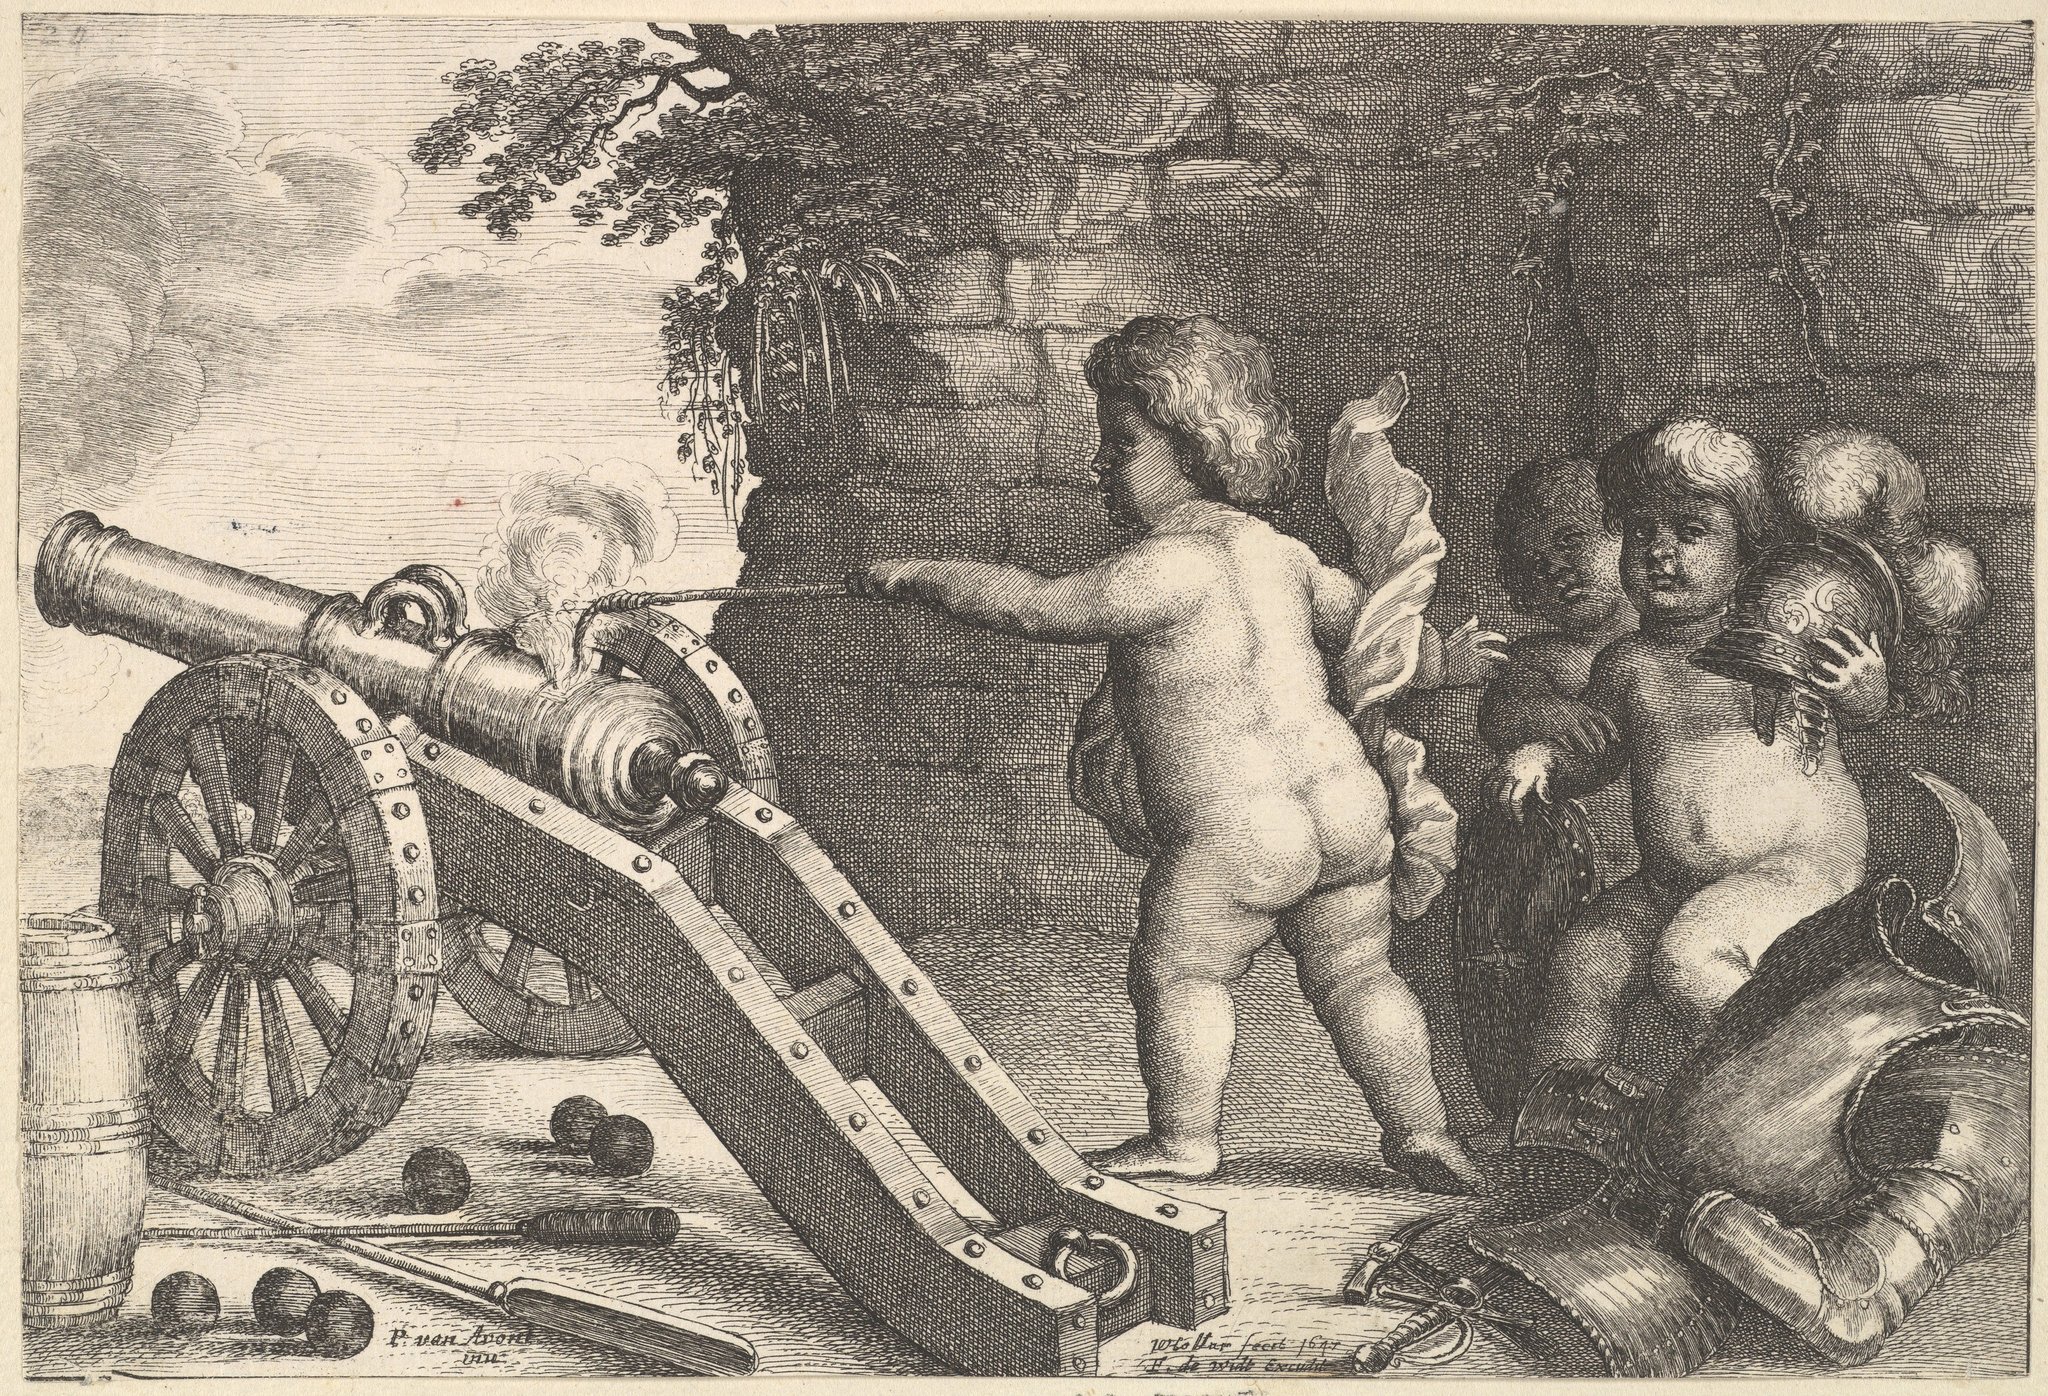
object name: print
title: Fire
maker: wenceslaus hollar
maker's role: artist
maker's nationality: bohemian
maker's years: 1607-1677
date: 1647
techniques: etching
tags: cannons,children